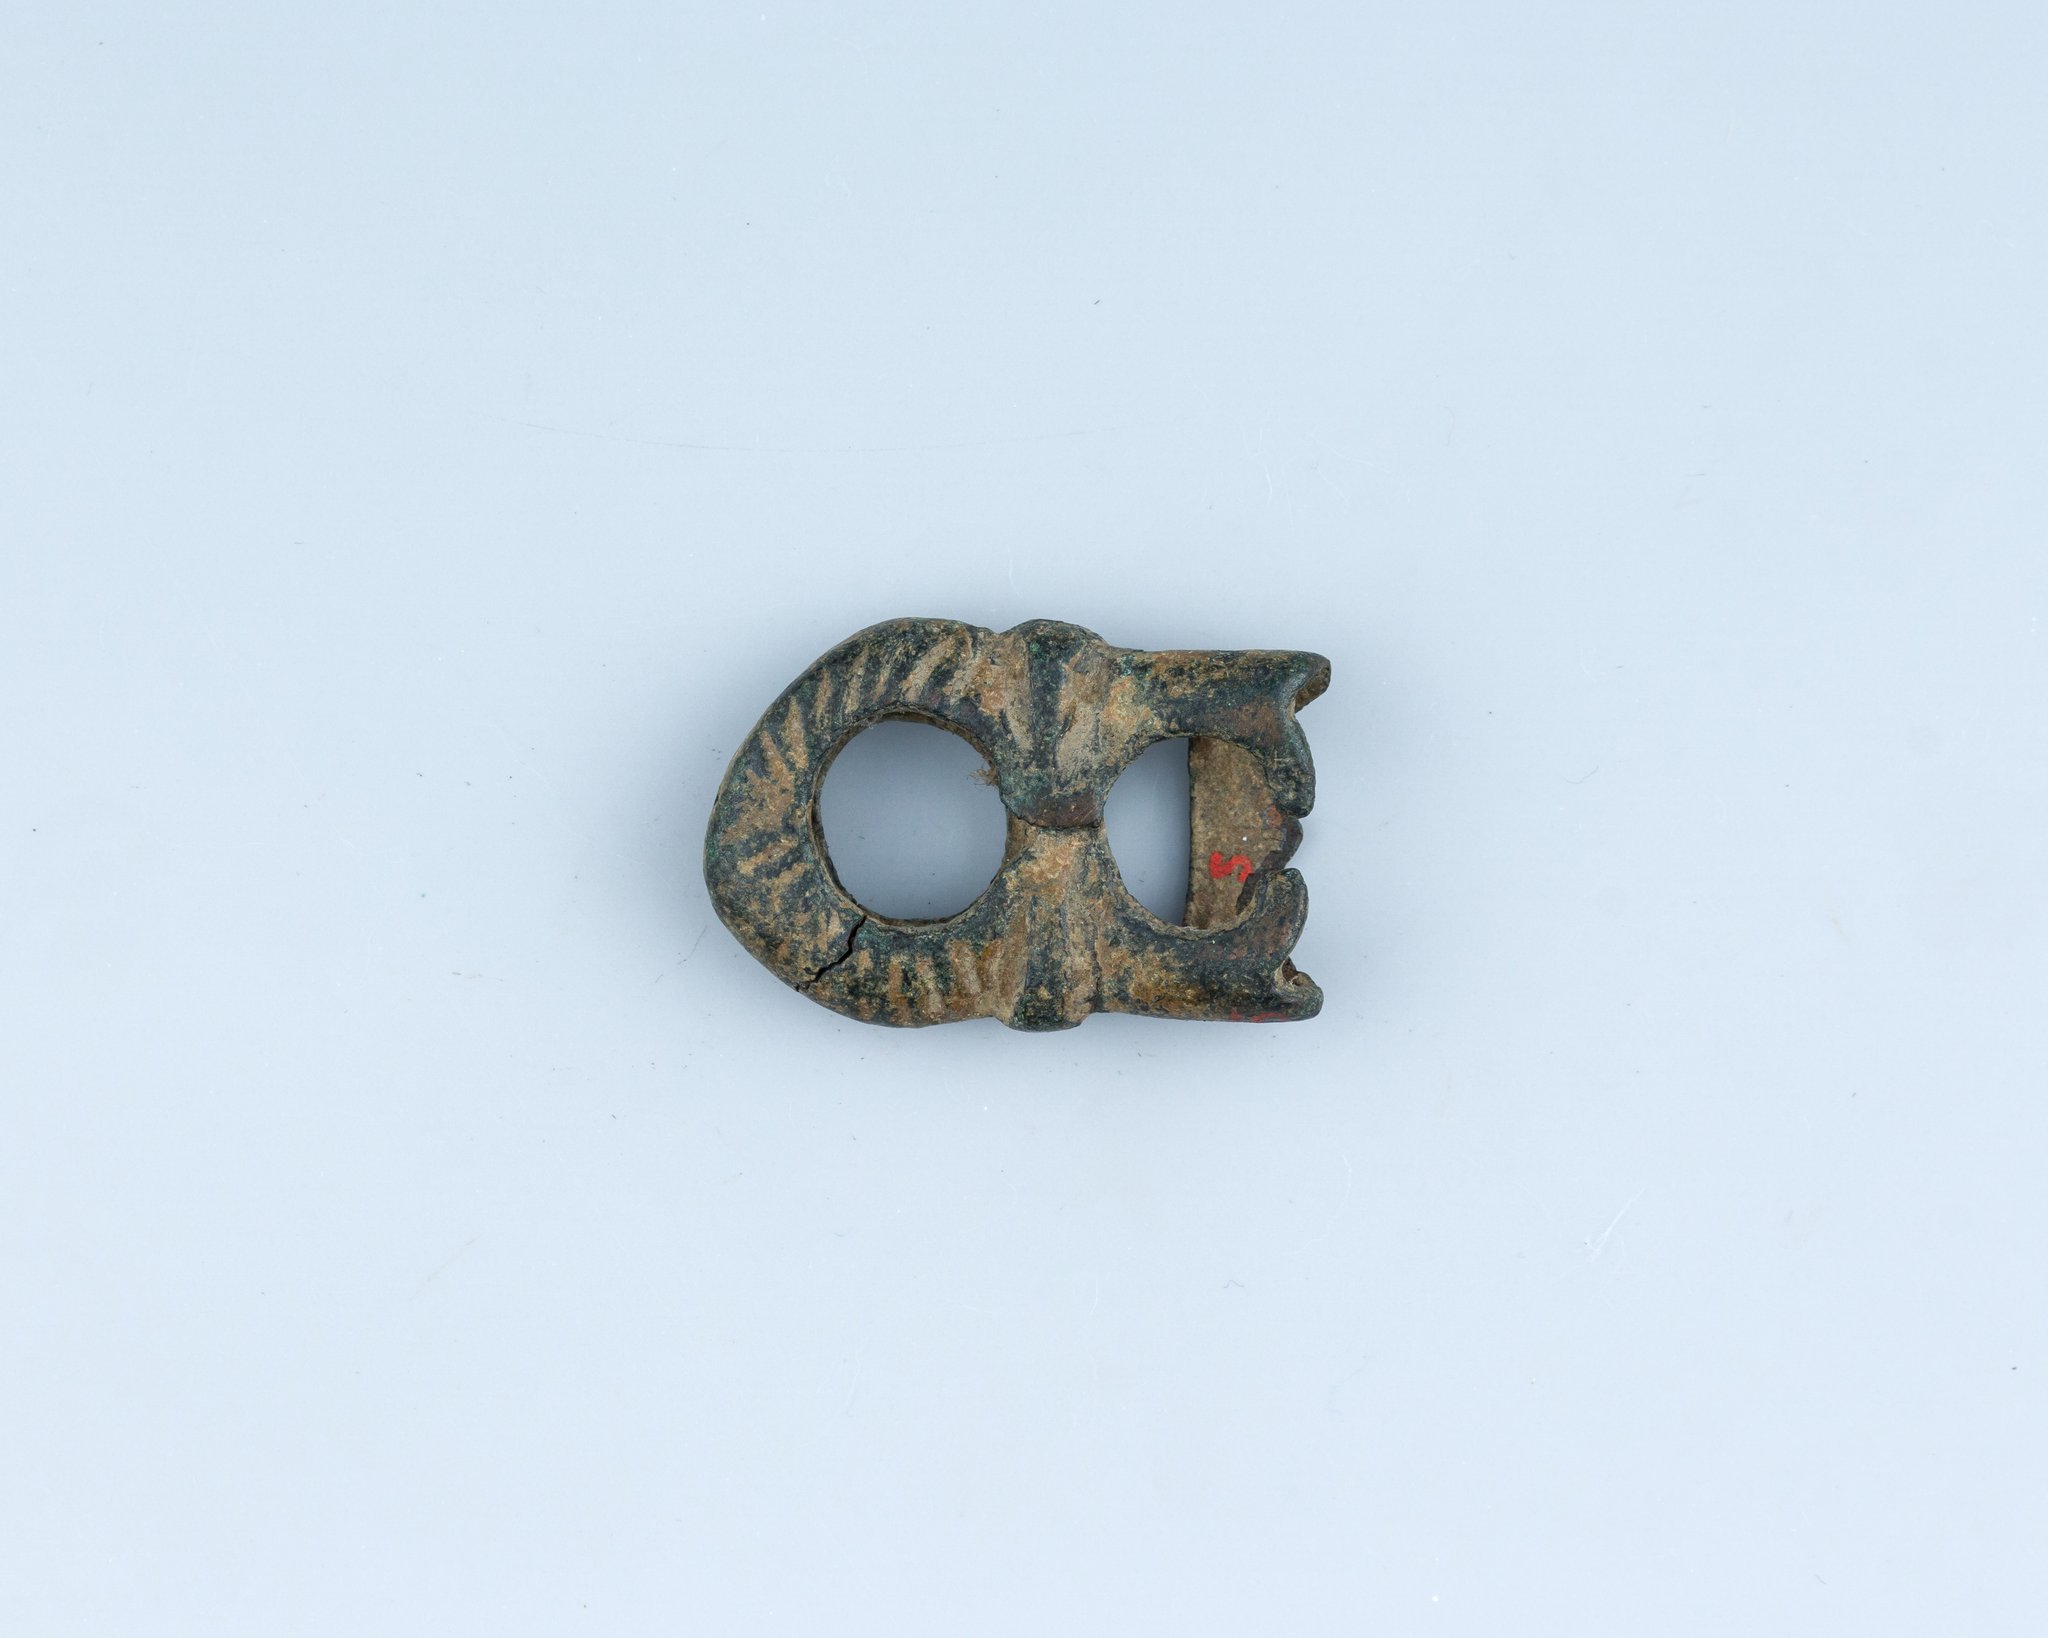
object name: mordant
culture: european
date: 1401-1700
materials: bronze